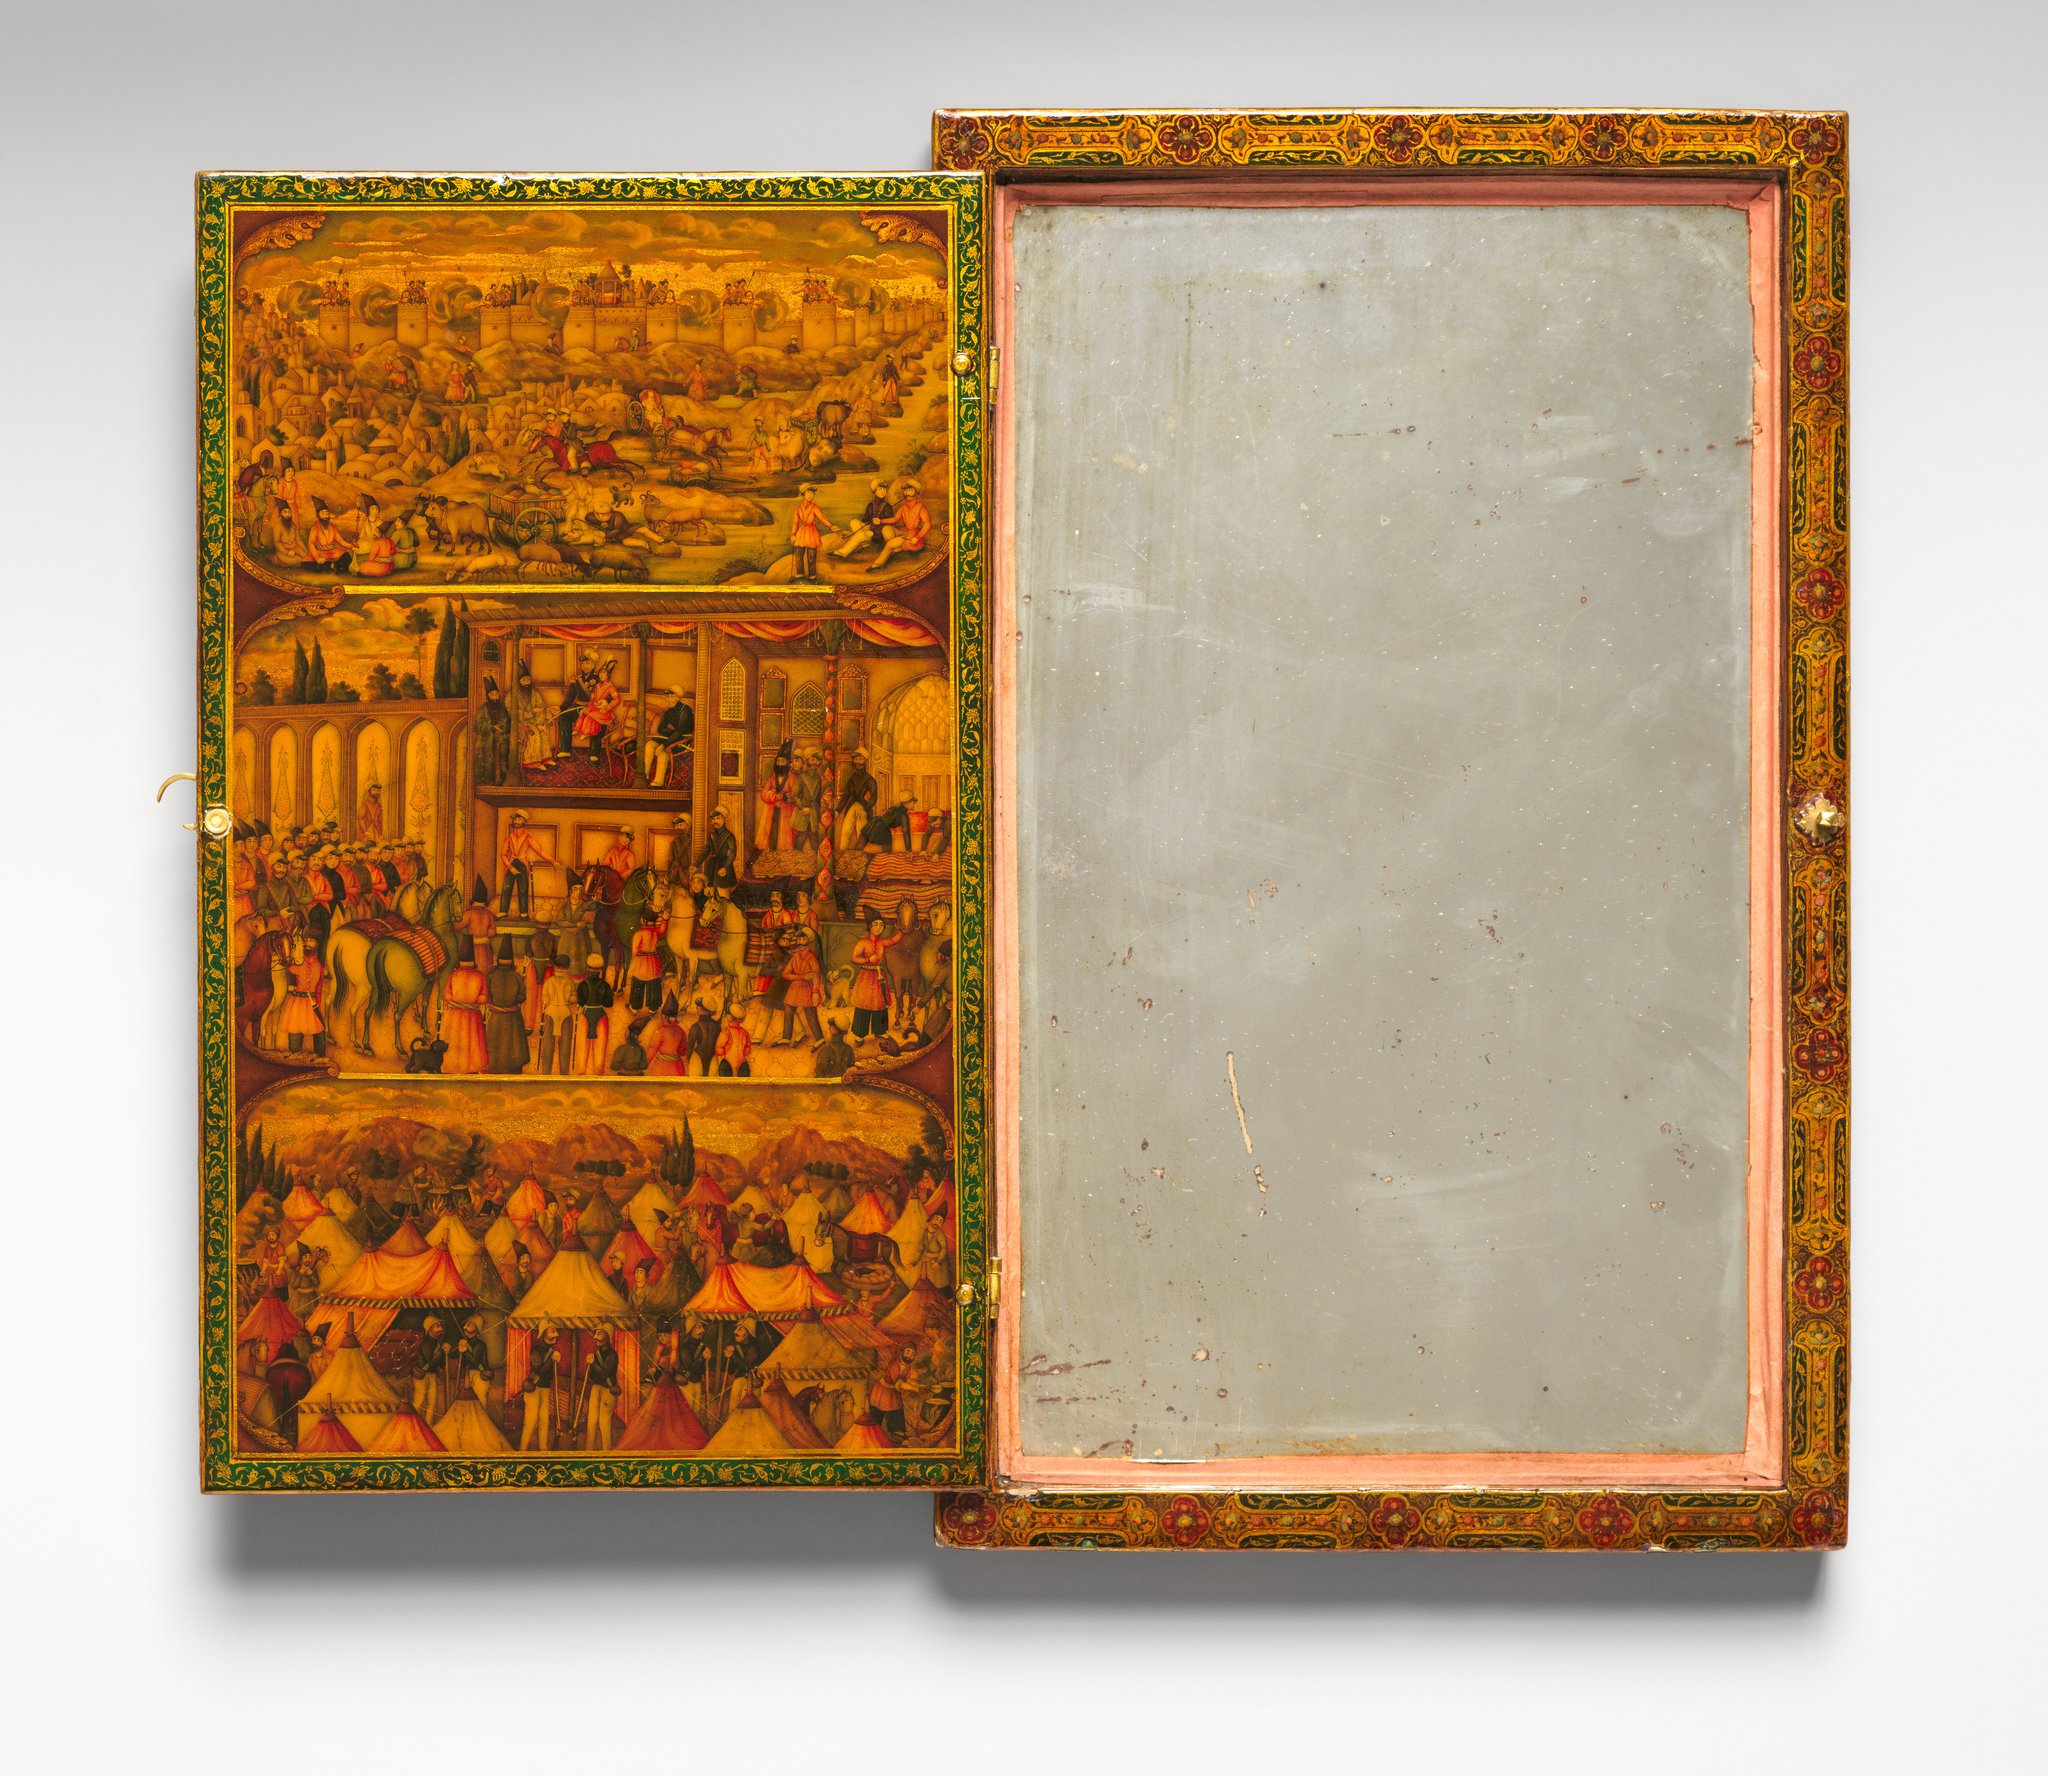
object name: mirror case with pouch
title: Mirror Case Depicting the Meeting of Nasir al-Din Mirza and Tsar Nicholas I in Erivan and Satin Pouch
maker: muhammad isma'il isfahani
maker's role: artist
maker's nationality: iranian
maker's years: 1789-1917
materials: gold, lacquer, metal, board, textile, varnish, watercolor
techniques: embroidery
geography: iran